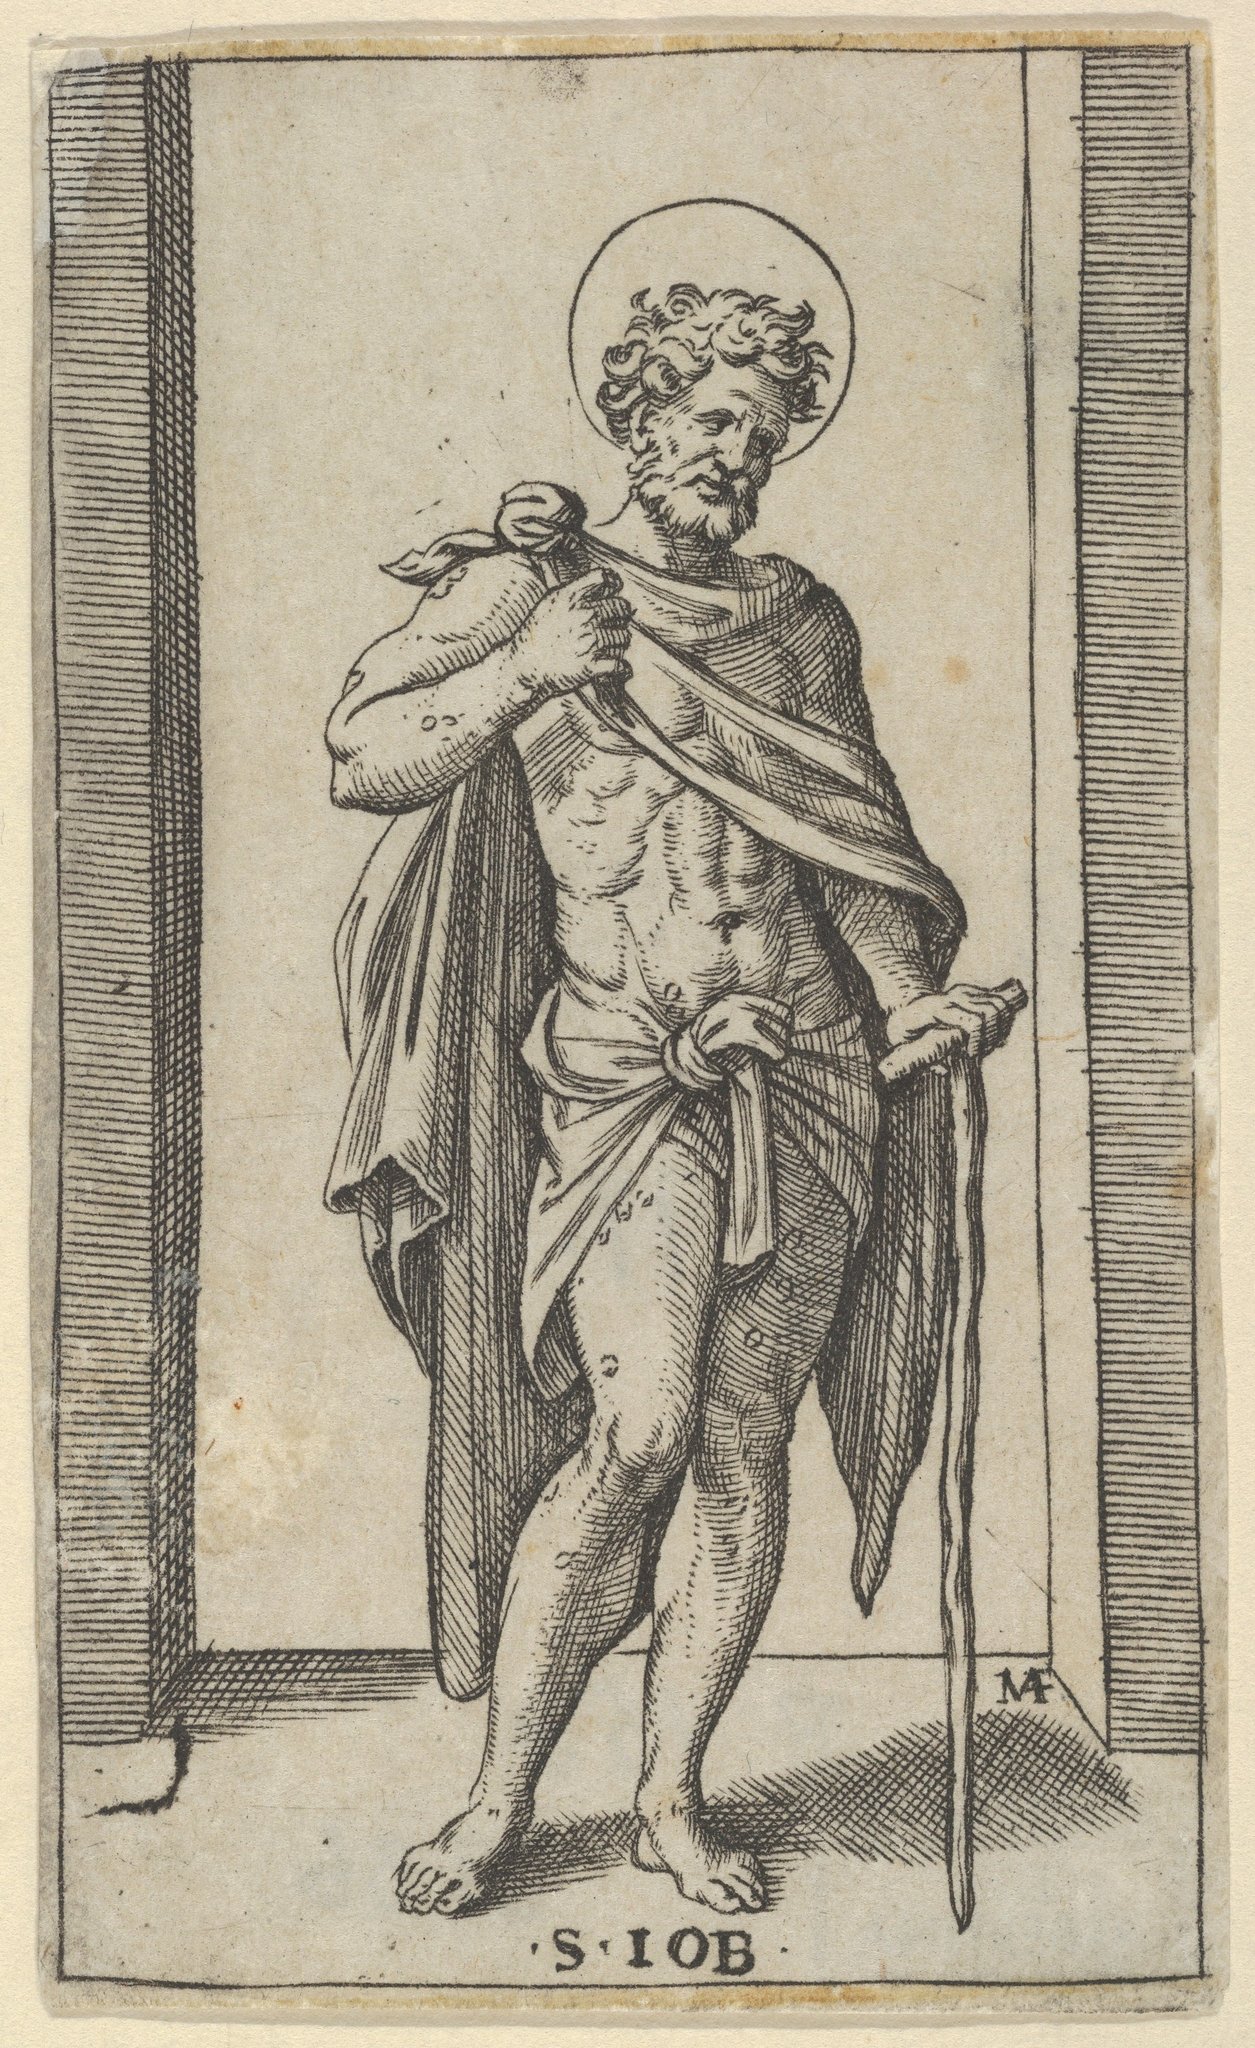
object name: print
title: Saint Job, wearing a cloak, from "Piccoli Santi" (Small Saints)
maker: marcantonio raimondi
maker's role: artist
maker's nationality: italian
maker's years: 1475-1534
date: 1500-1527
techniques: engraving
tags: men,saints